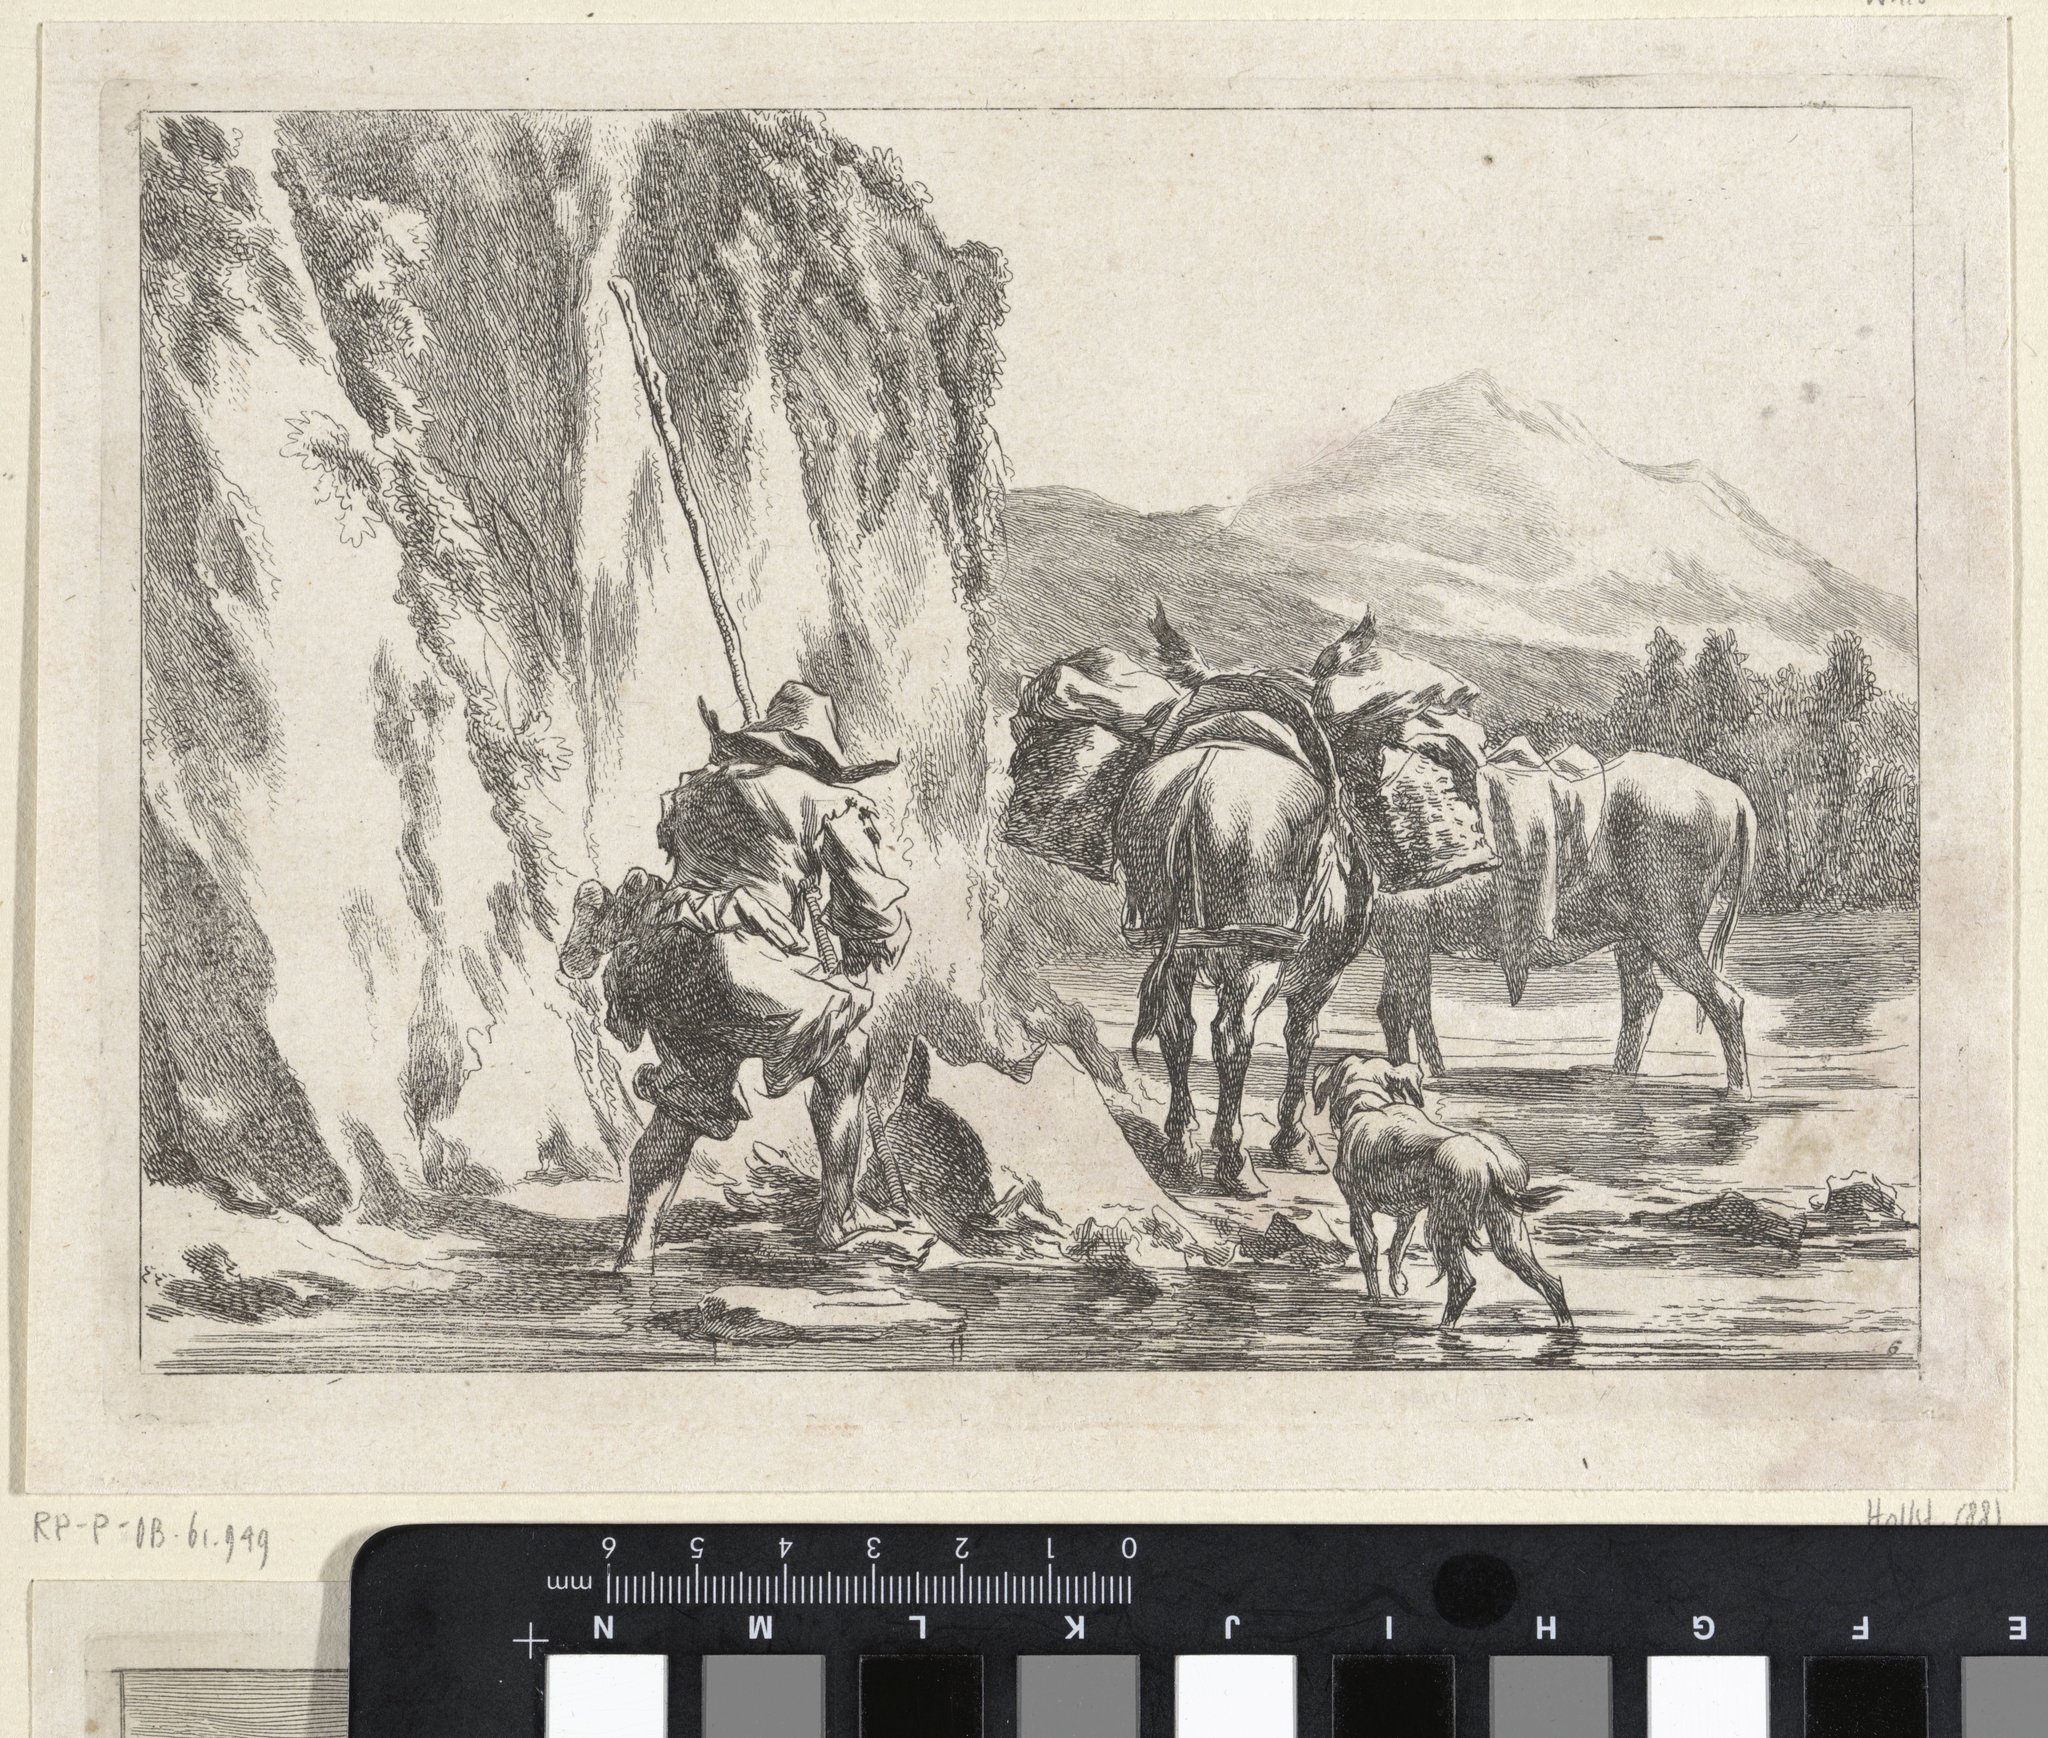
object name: print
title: Twee ezels en een herder bij een voorde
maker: jan de visscher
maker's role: print maker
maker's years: 1633-1712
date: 1643-1701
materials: paper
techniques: etching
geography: northern netherlands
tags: ass, donkey, herding, herdsman, herdswoman, shepherd, shepherdess, cowherd, etc., ford, dog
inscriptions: collector's mark: Lugt 240